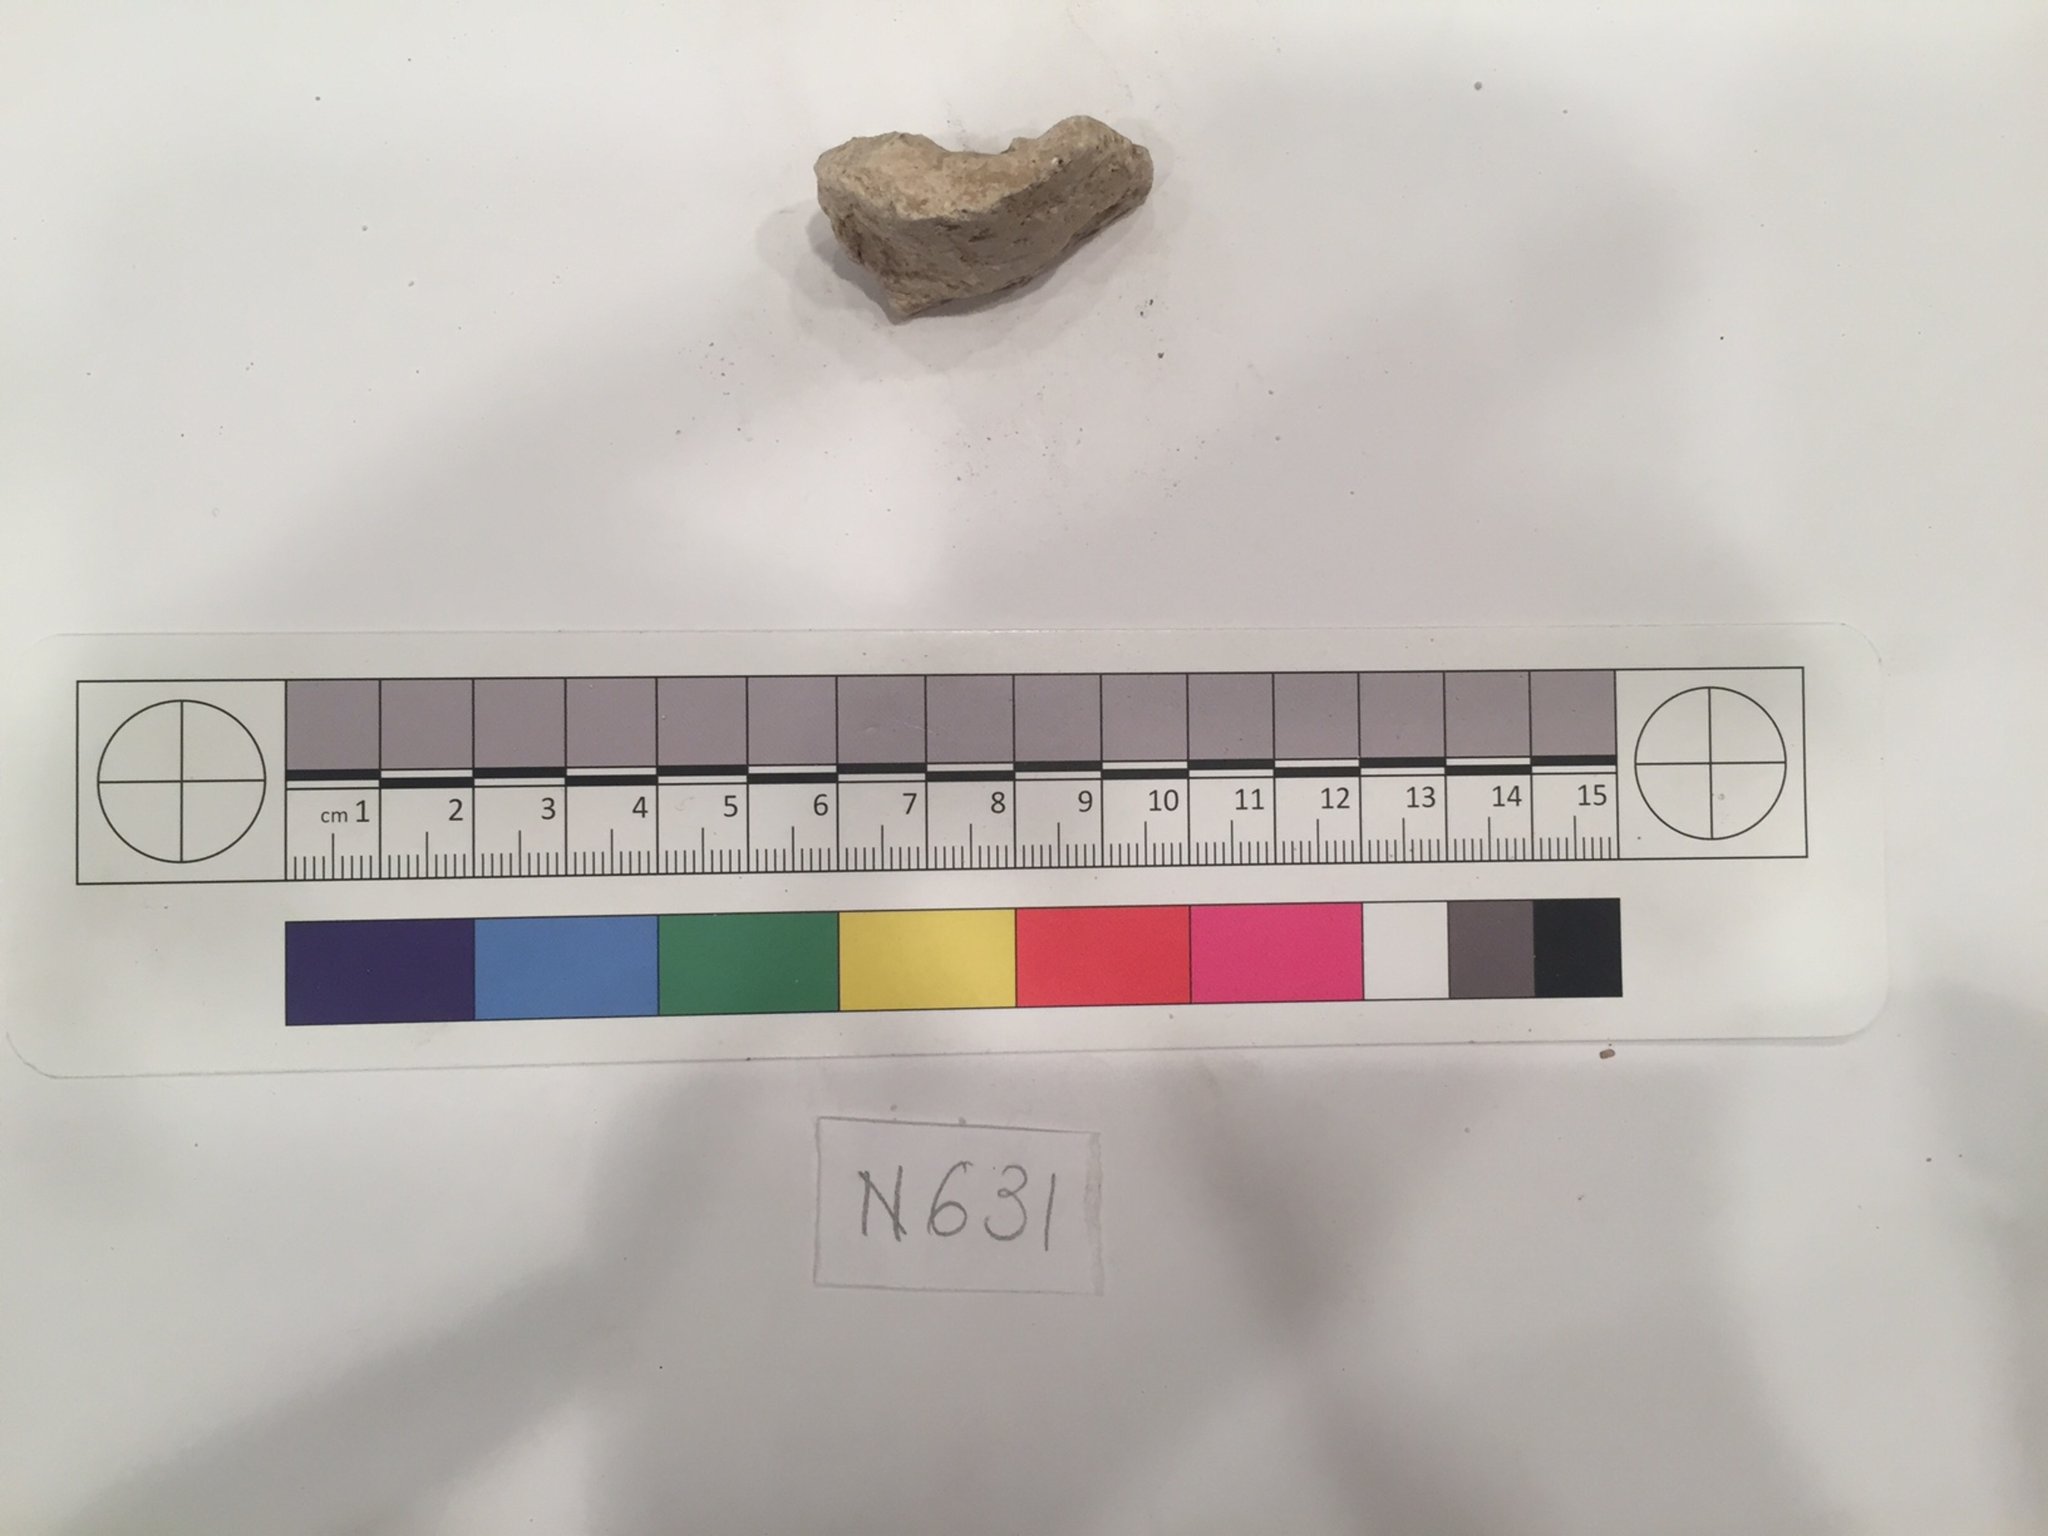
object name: fragment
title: Stucco Fragment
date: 701-1200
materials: plaster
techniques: carving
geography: iran